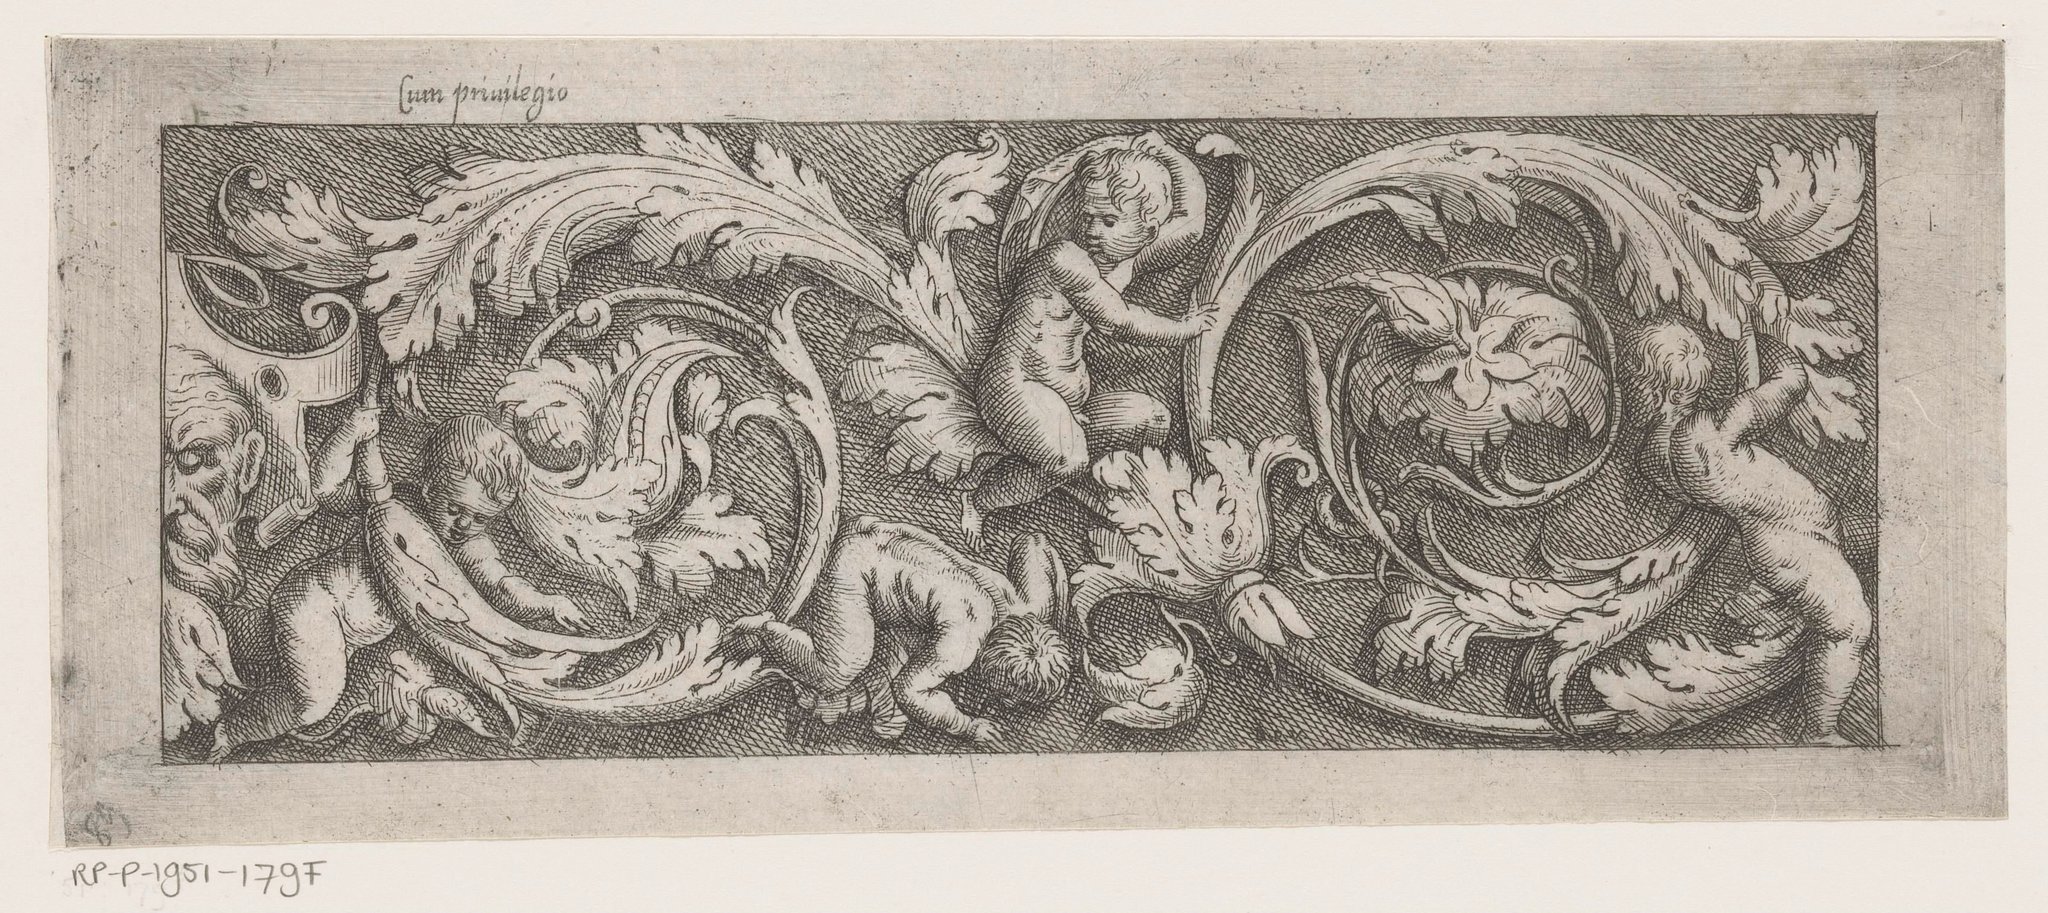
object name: print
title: Fries met arabesken en vier putti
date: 1561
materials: paper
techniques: etching, intaglio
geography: venice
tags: ornaments ~ art, foliage ~ ornament, cupids: 'amores', 'amoretti', 'putti'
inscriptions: collector's mark: Lugt 2228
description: Deze prent maakt onderdeel uit van een reeks.